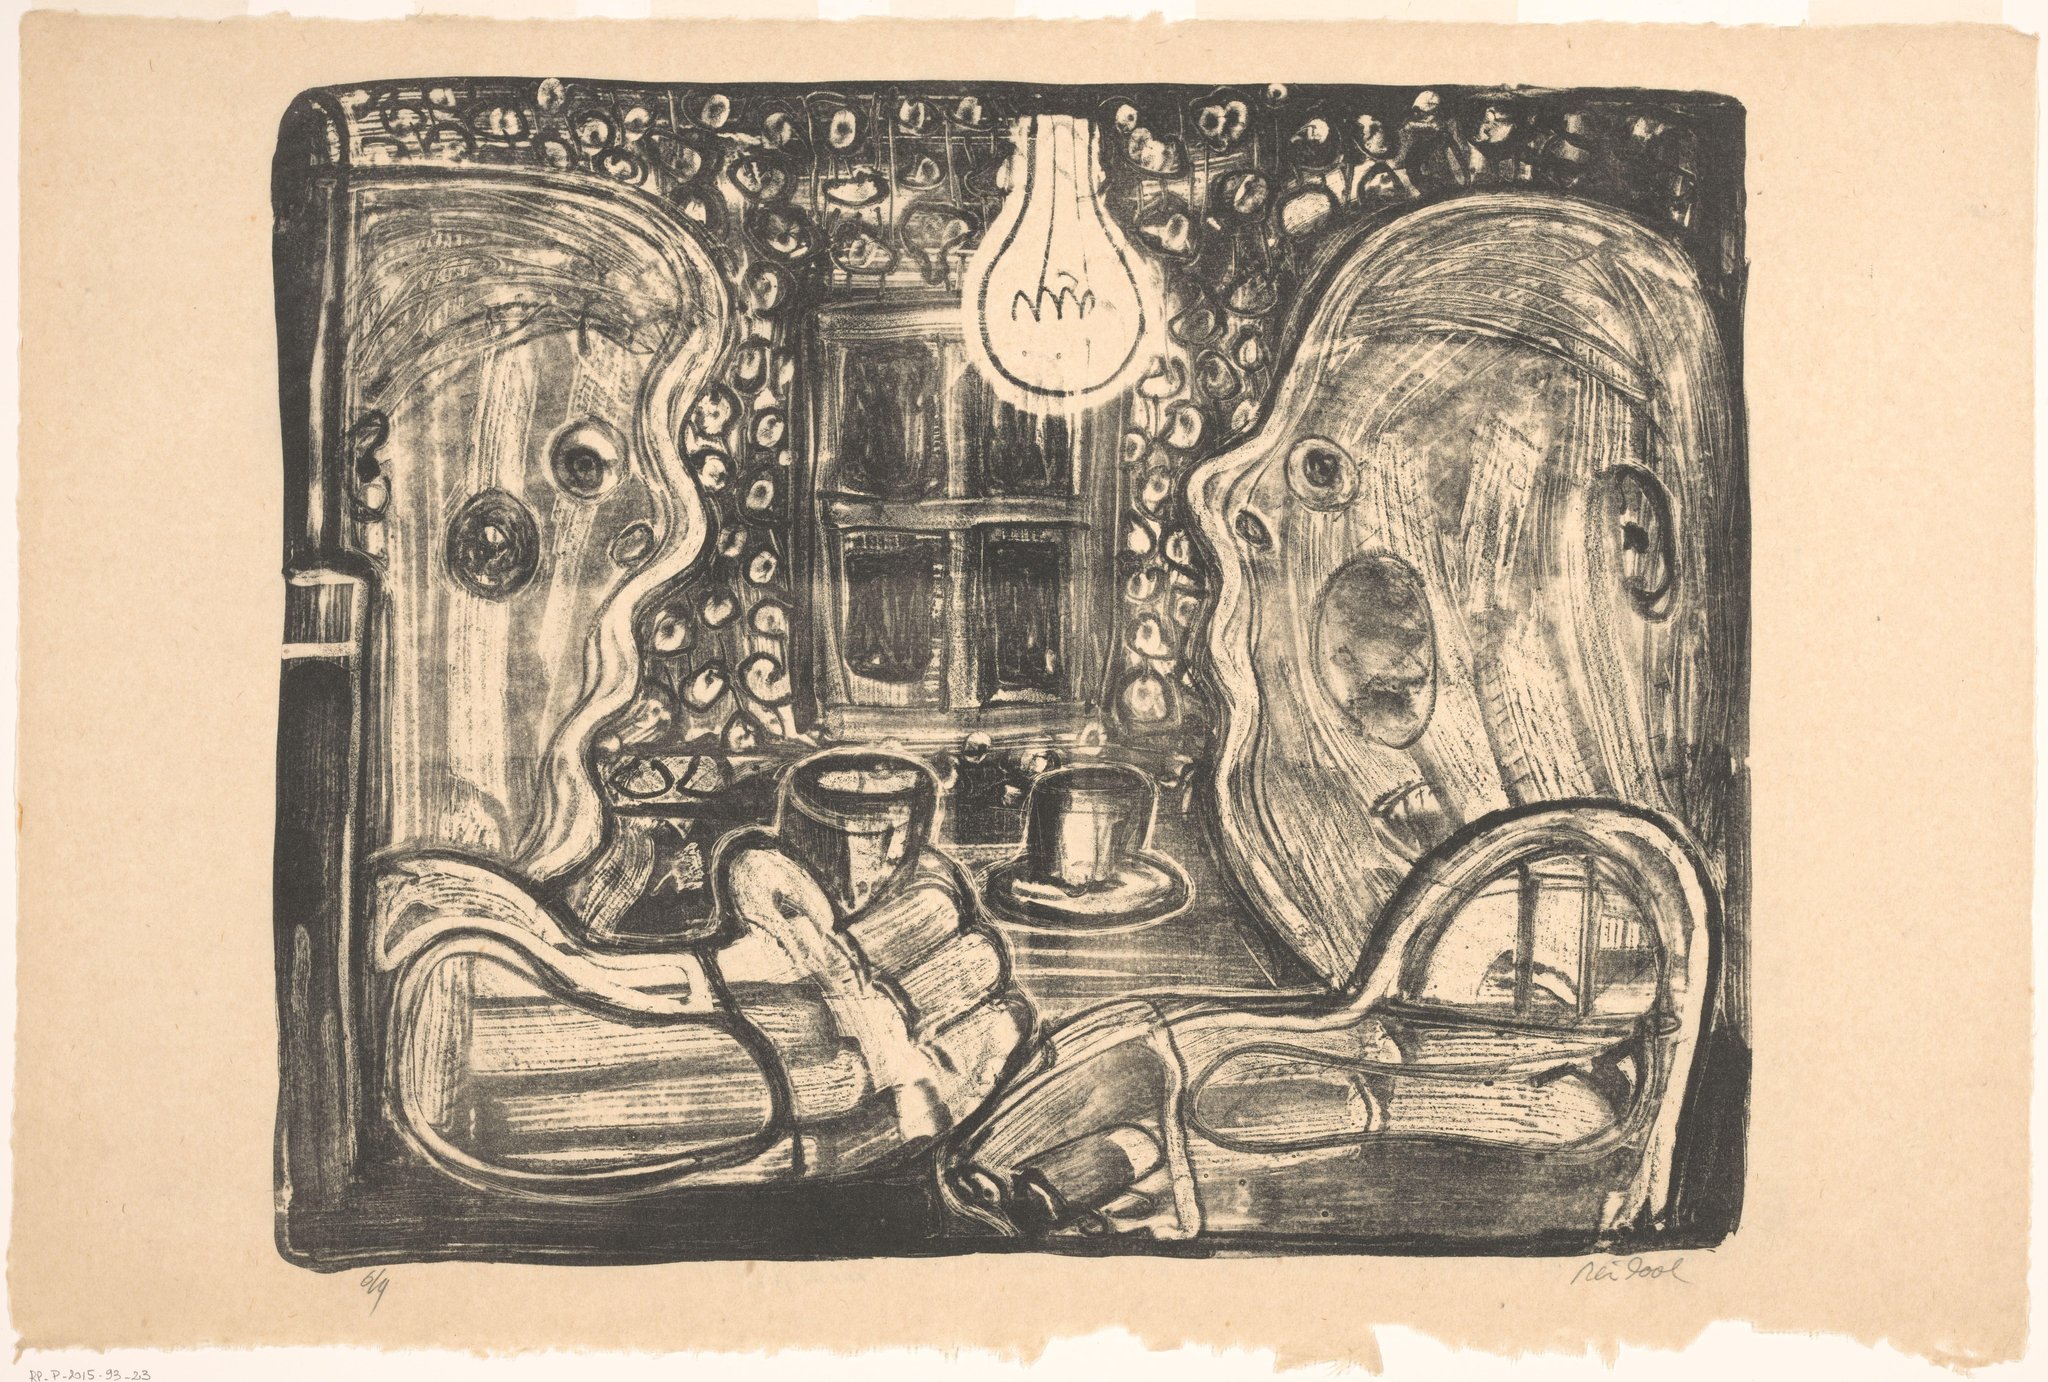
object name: print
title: Koffie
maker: rein dool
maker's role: draughtsman, painter, print maker, sculptor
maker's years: 1933-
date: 1985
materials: paper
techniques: lithograph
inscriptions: signature